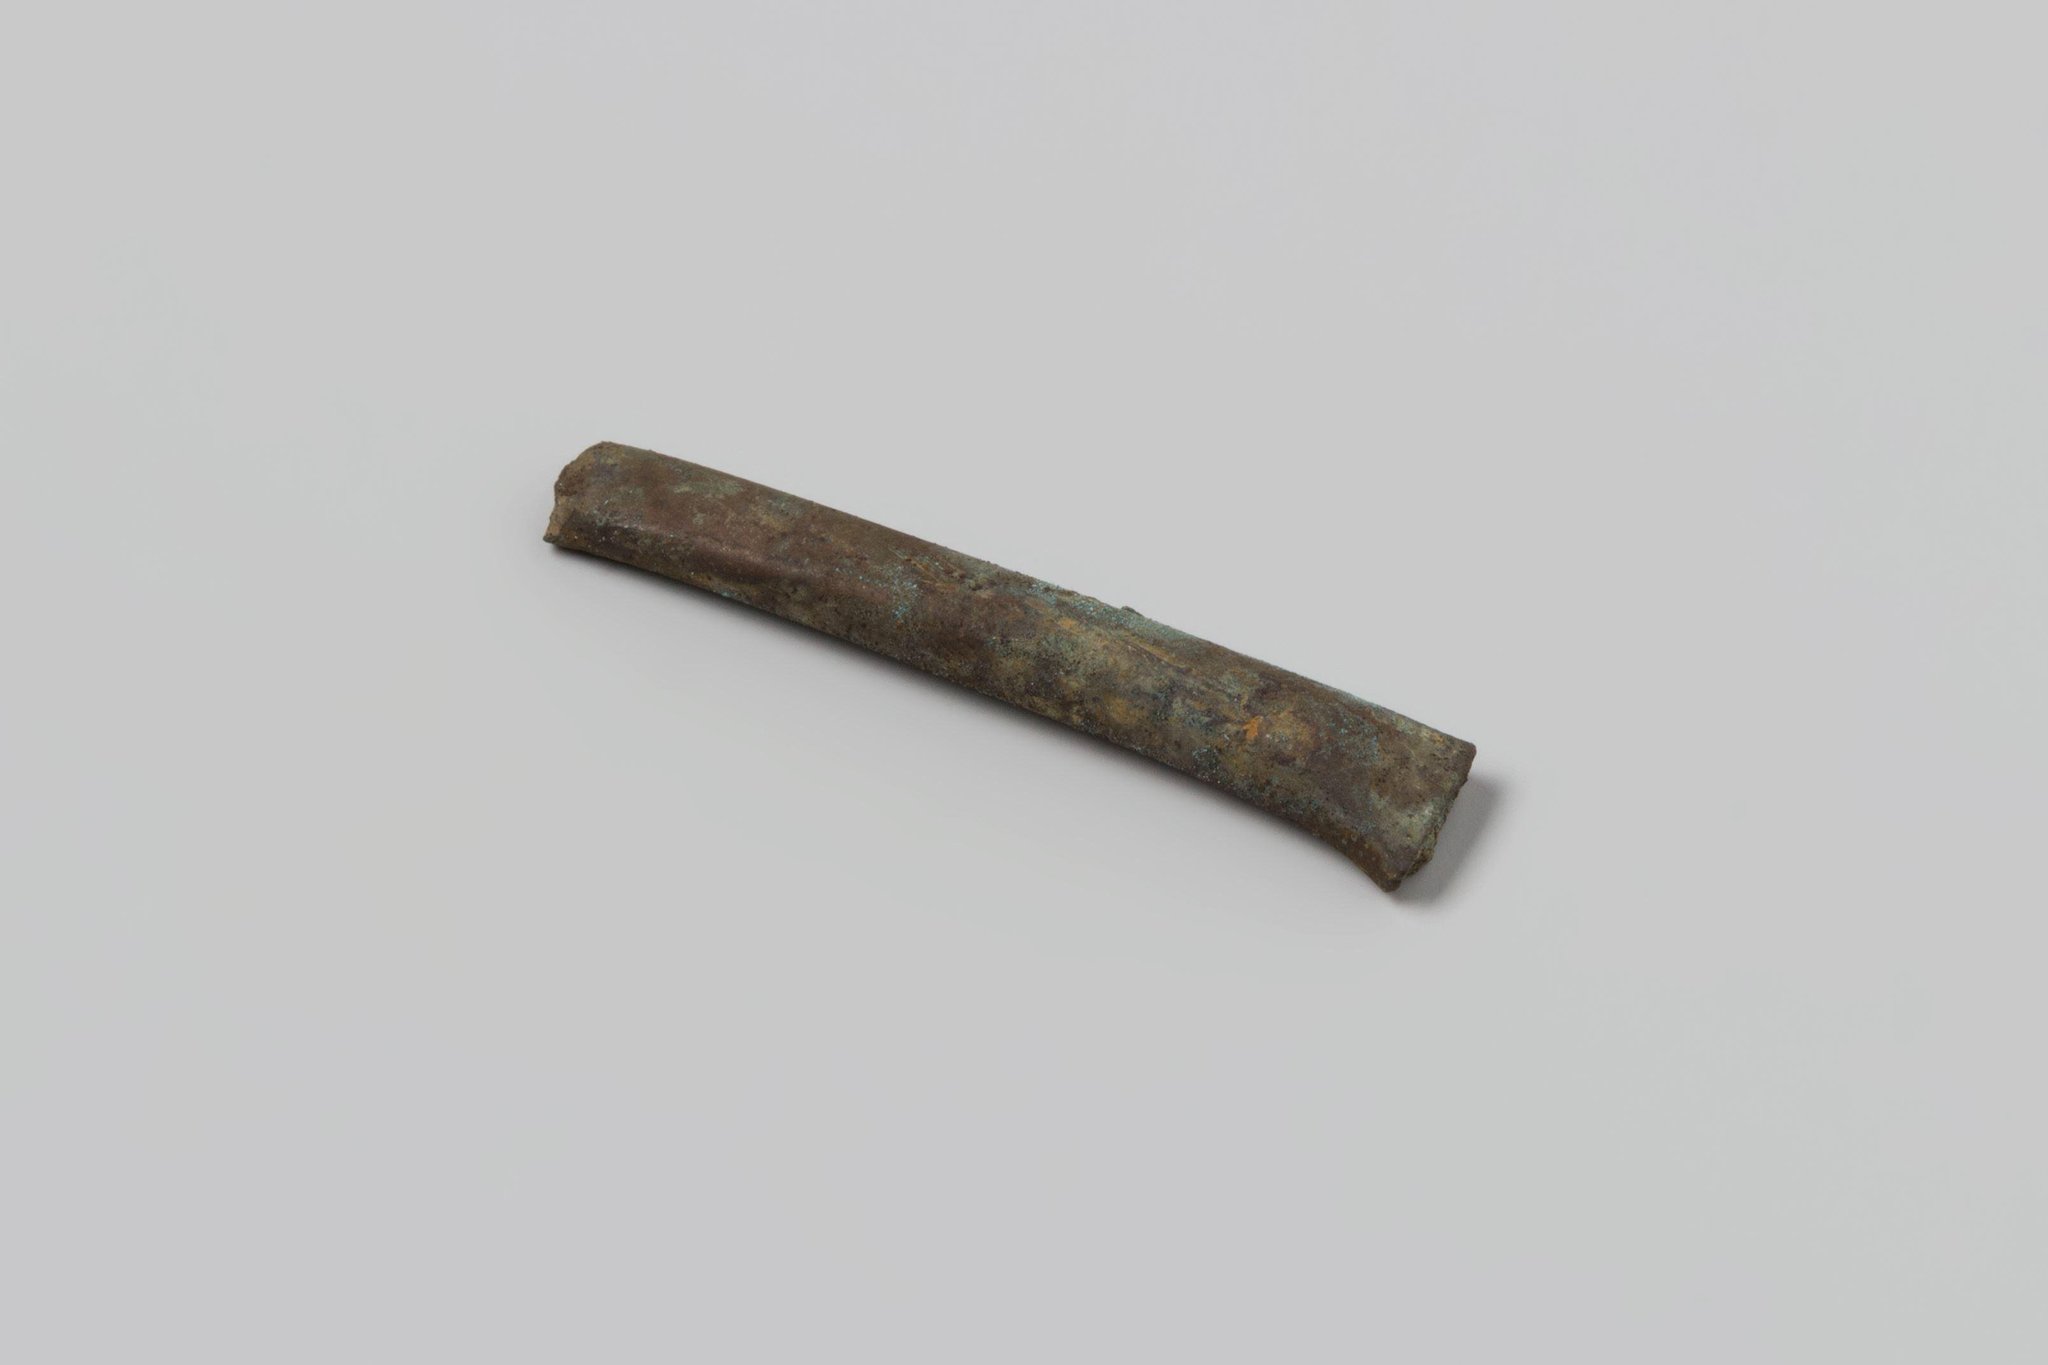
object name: spoon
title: Fragment steel van vork of lepel uit het wrak van de Oost-Indiëvaarder Hollandia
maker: Anonymous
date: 1700-1743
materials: copper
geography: netherlands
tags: verenigde oostindische compagnie, hollandia (schip), annet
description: Cutlery, fragment: stem of fork or spoon; fragm, sim. NG 1980-27H536a.